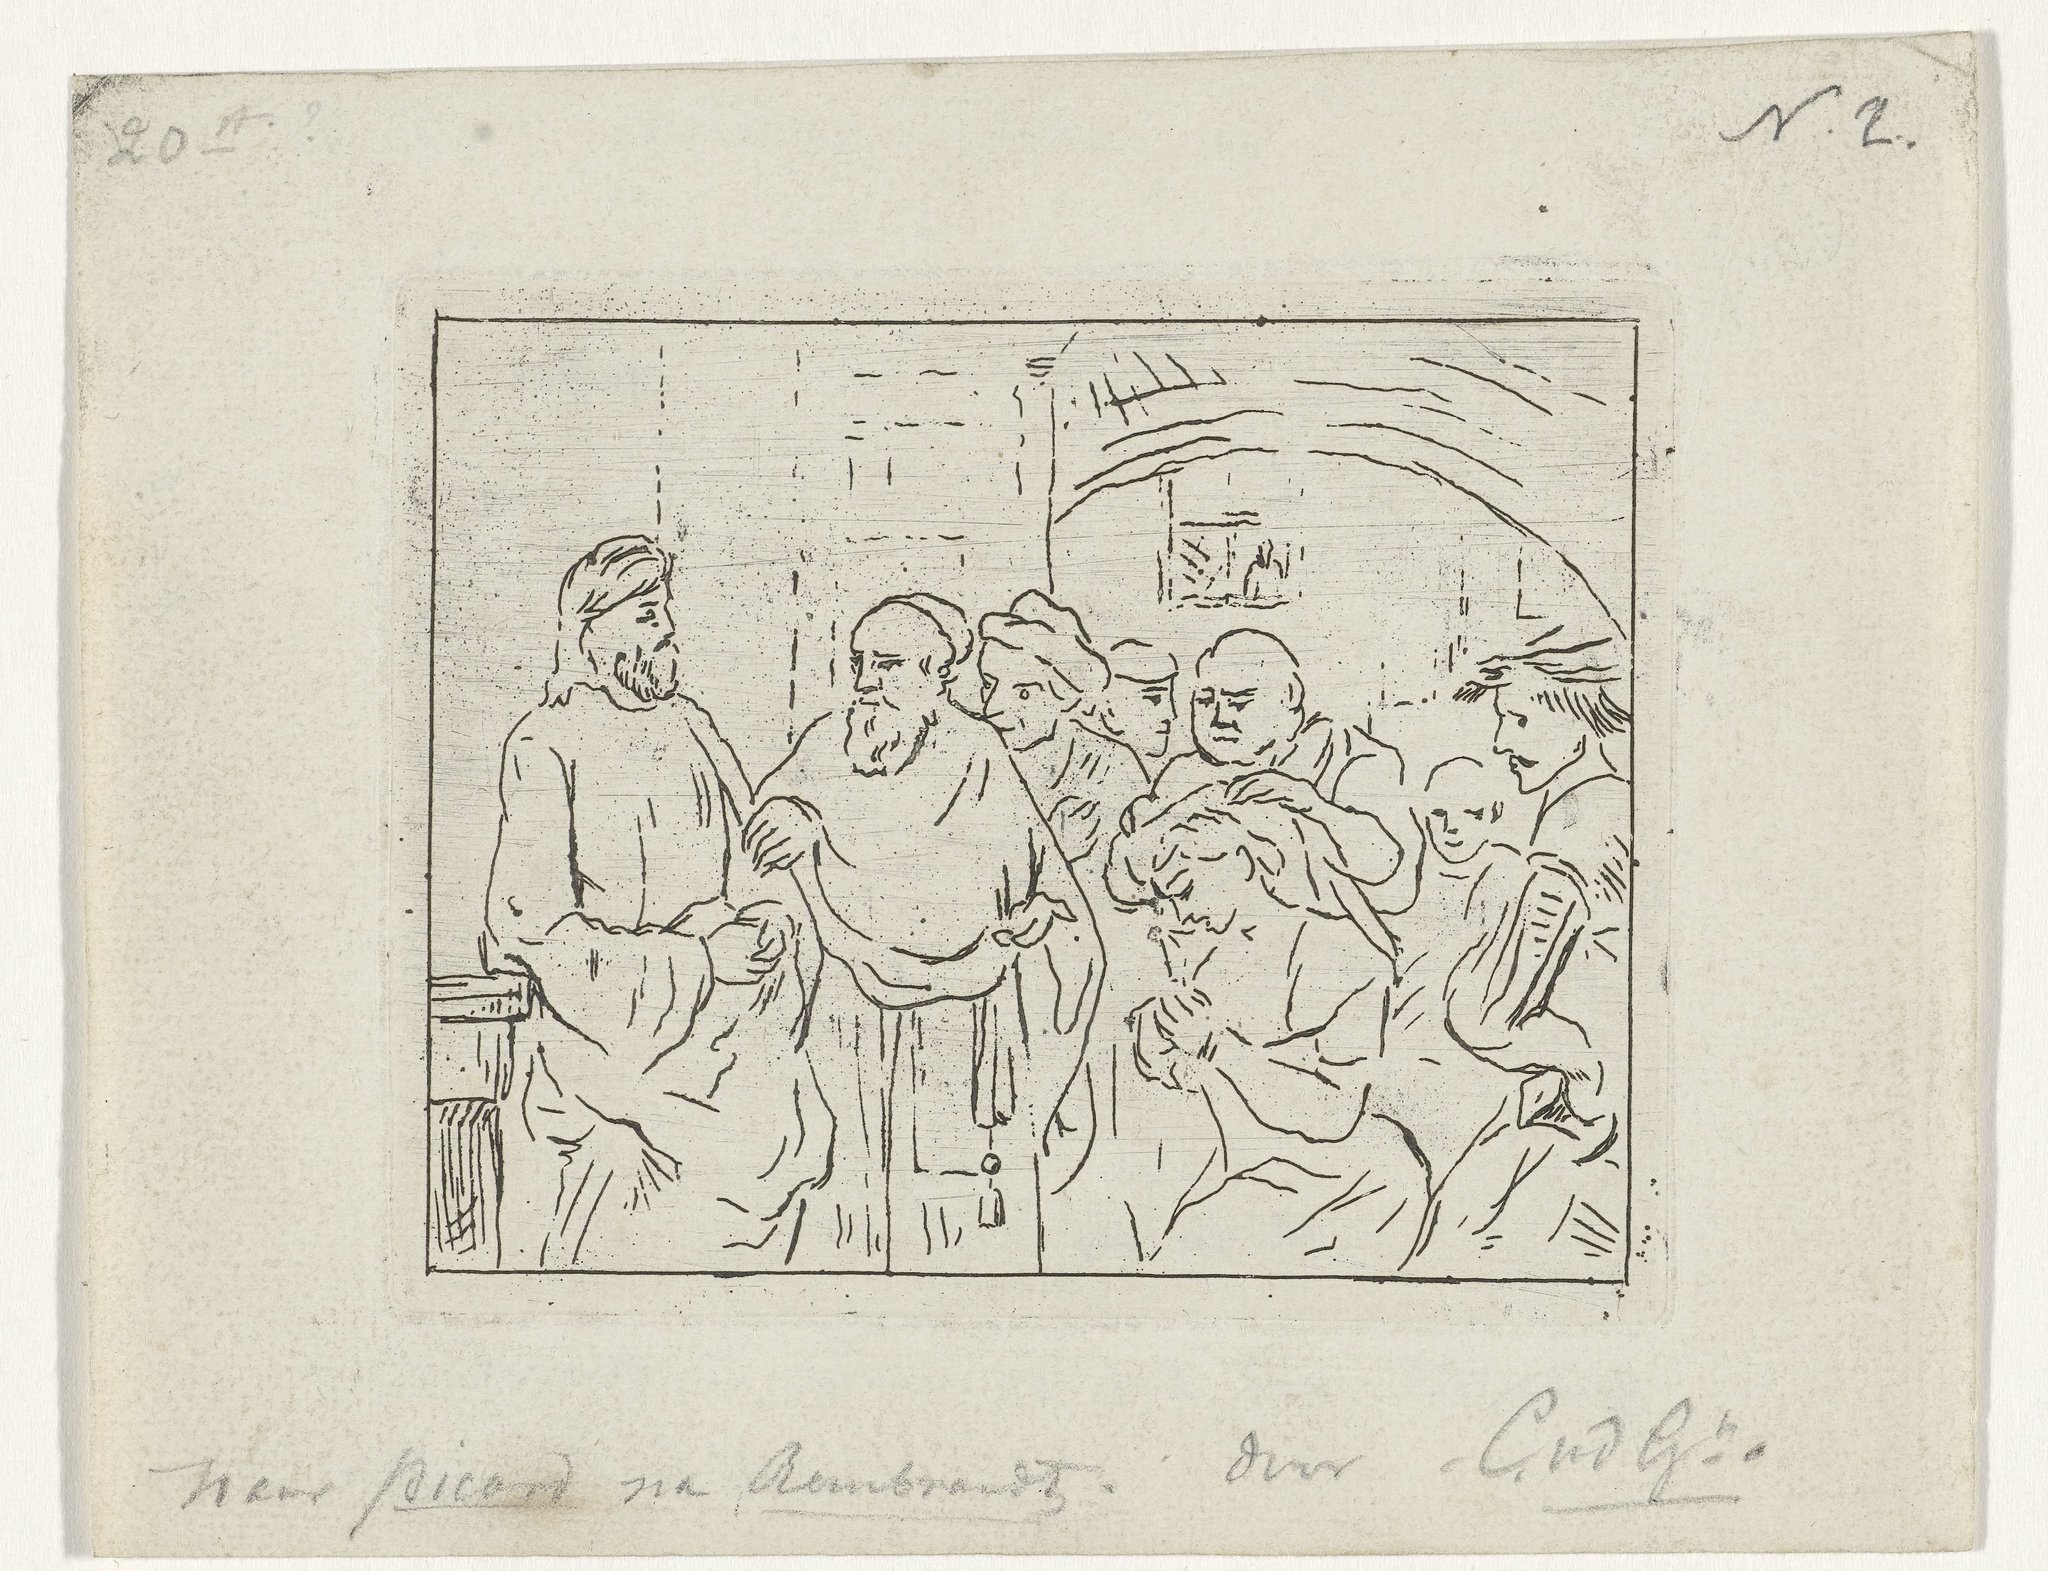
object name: print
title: Christus en de overspelige vrouw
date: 1837-1918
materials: paper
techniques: etching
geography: netherlands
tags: pharisees bring a woman accused of adultery before christ (john 8:2-11)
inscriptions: collector's mark: Lugt 2228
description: Geïnspireerd op Rembrandts 'Christus en de overspelige vrouw'. Afgebeeld is het moment waarop de Farizeeën Christus een strikvraag stellen.